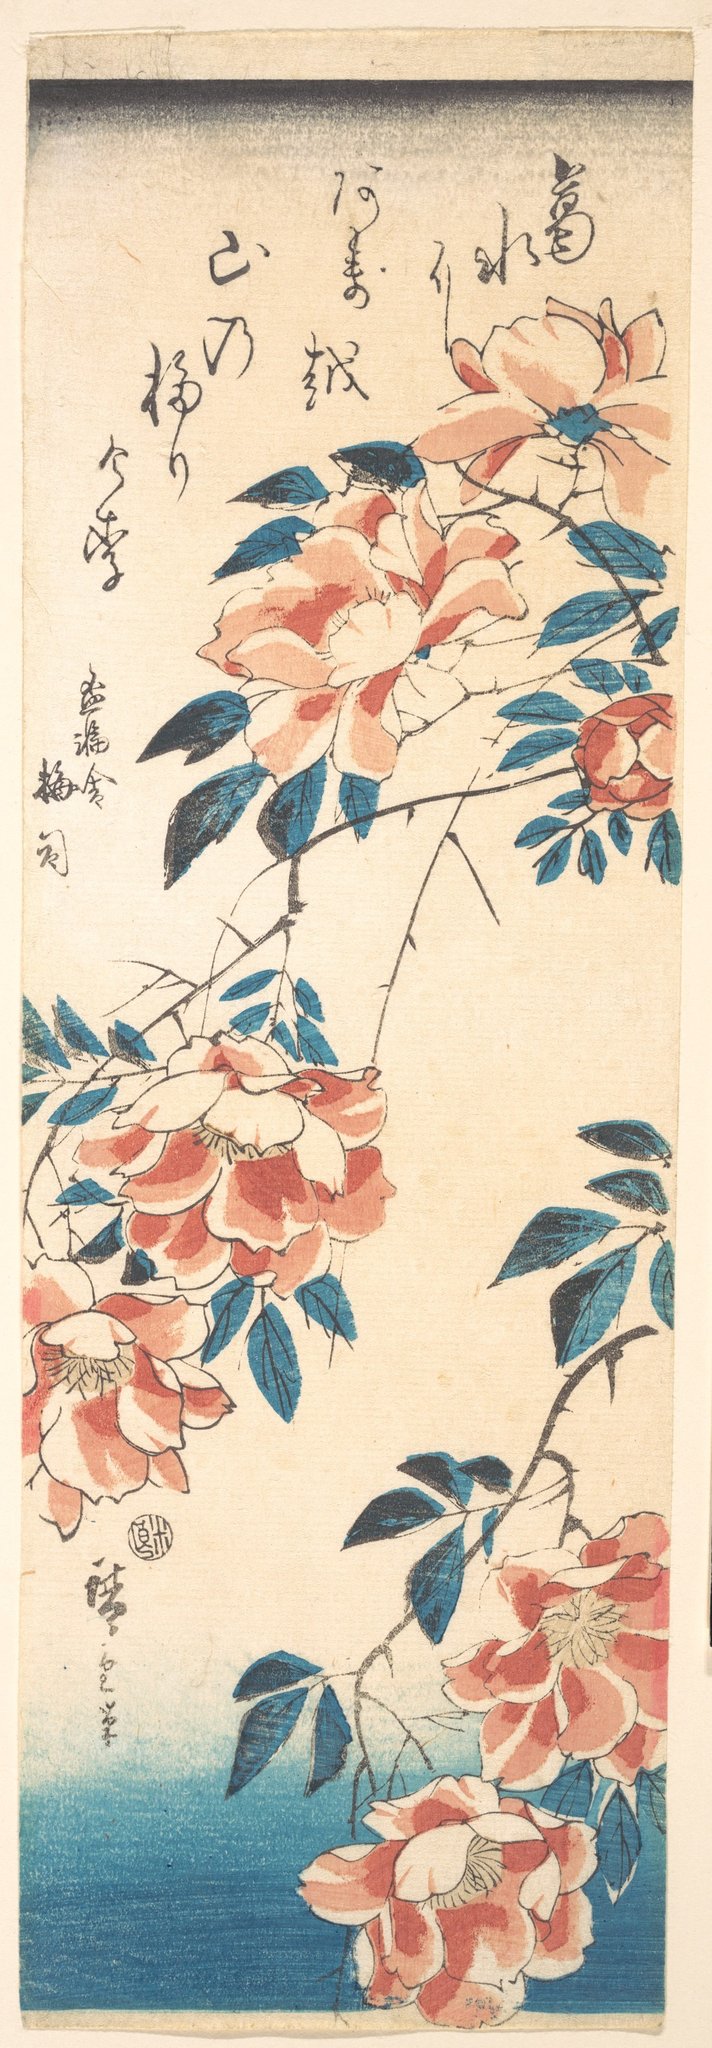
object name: print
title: Rose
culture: japanese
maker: utagawa hiroshige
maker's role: artist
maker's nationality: japanese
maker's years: 1797-1858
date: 1615-1868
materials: ink, paper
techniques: woodblock print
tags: roses